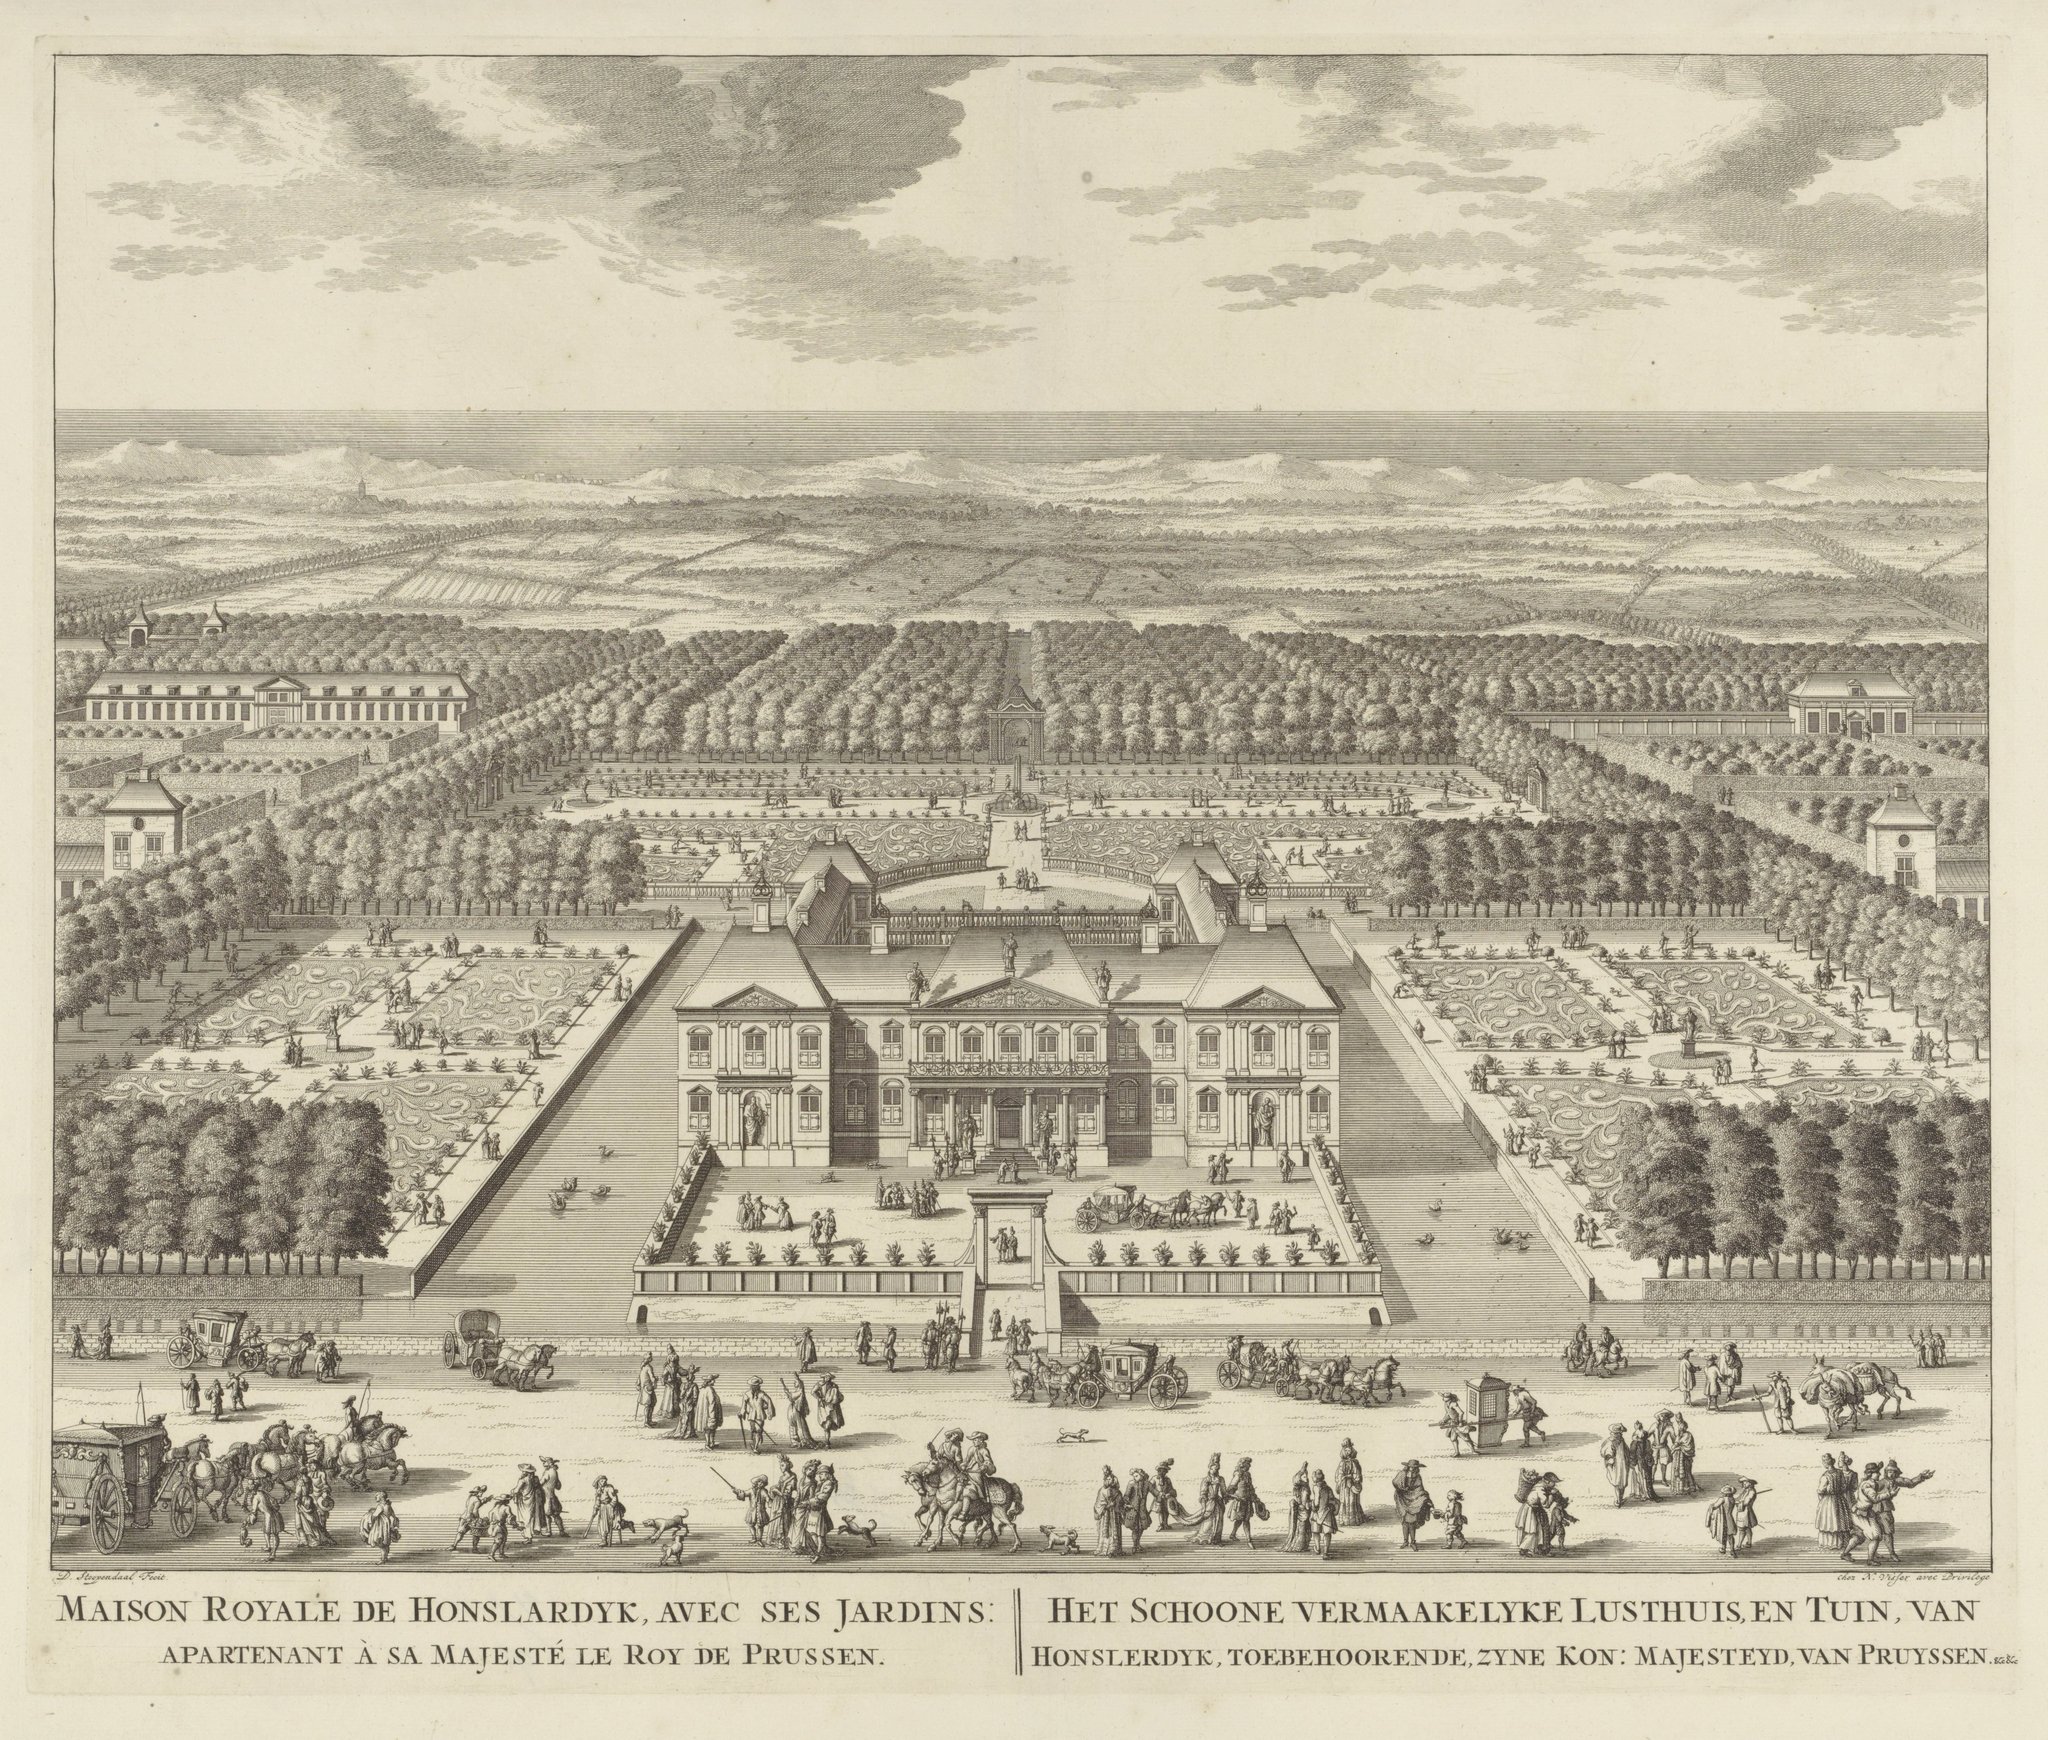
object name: print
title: Paleis Honselaarsdijk in vogelvlucht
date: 1682-1726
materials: paper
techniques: etching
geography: amsterdam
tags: palace, bird's eye view ~ representation of building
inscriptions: collector's mark: Lugt 2228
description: Gezicht op Paleis Honselaarsdijk met de tuinen en landerijen in vogelvlucht. Op het voorplein een koets met vier paarden. Op de voorgrond koetsen, een draagstoel, elegant geklede wandelaars, ruiters, bedelaars en kooplieden.